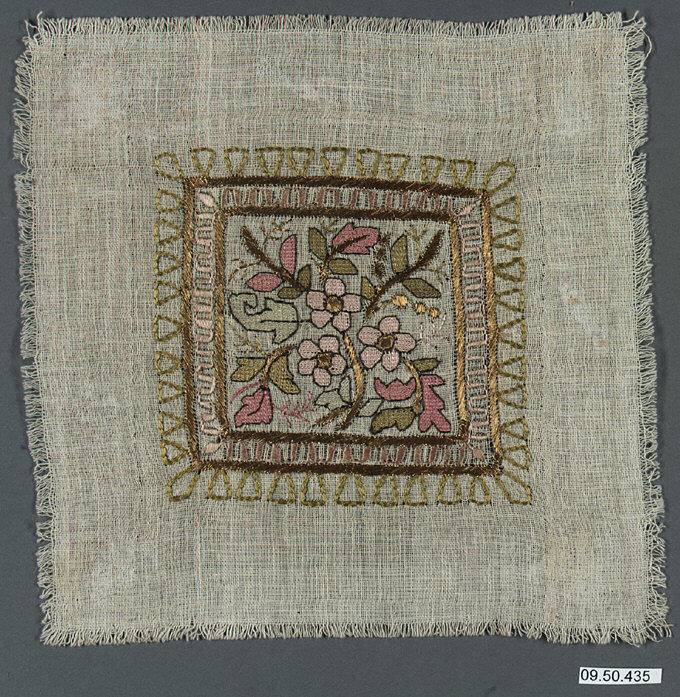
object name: square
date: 1801-1900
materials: linen, metal thread, silk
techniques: embroidery, weave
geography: turkey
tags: flowers